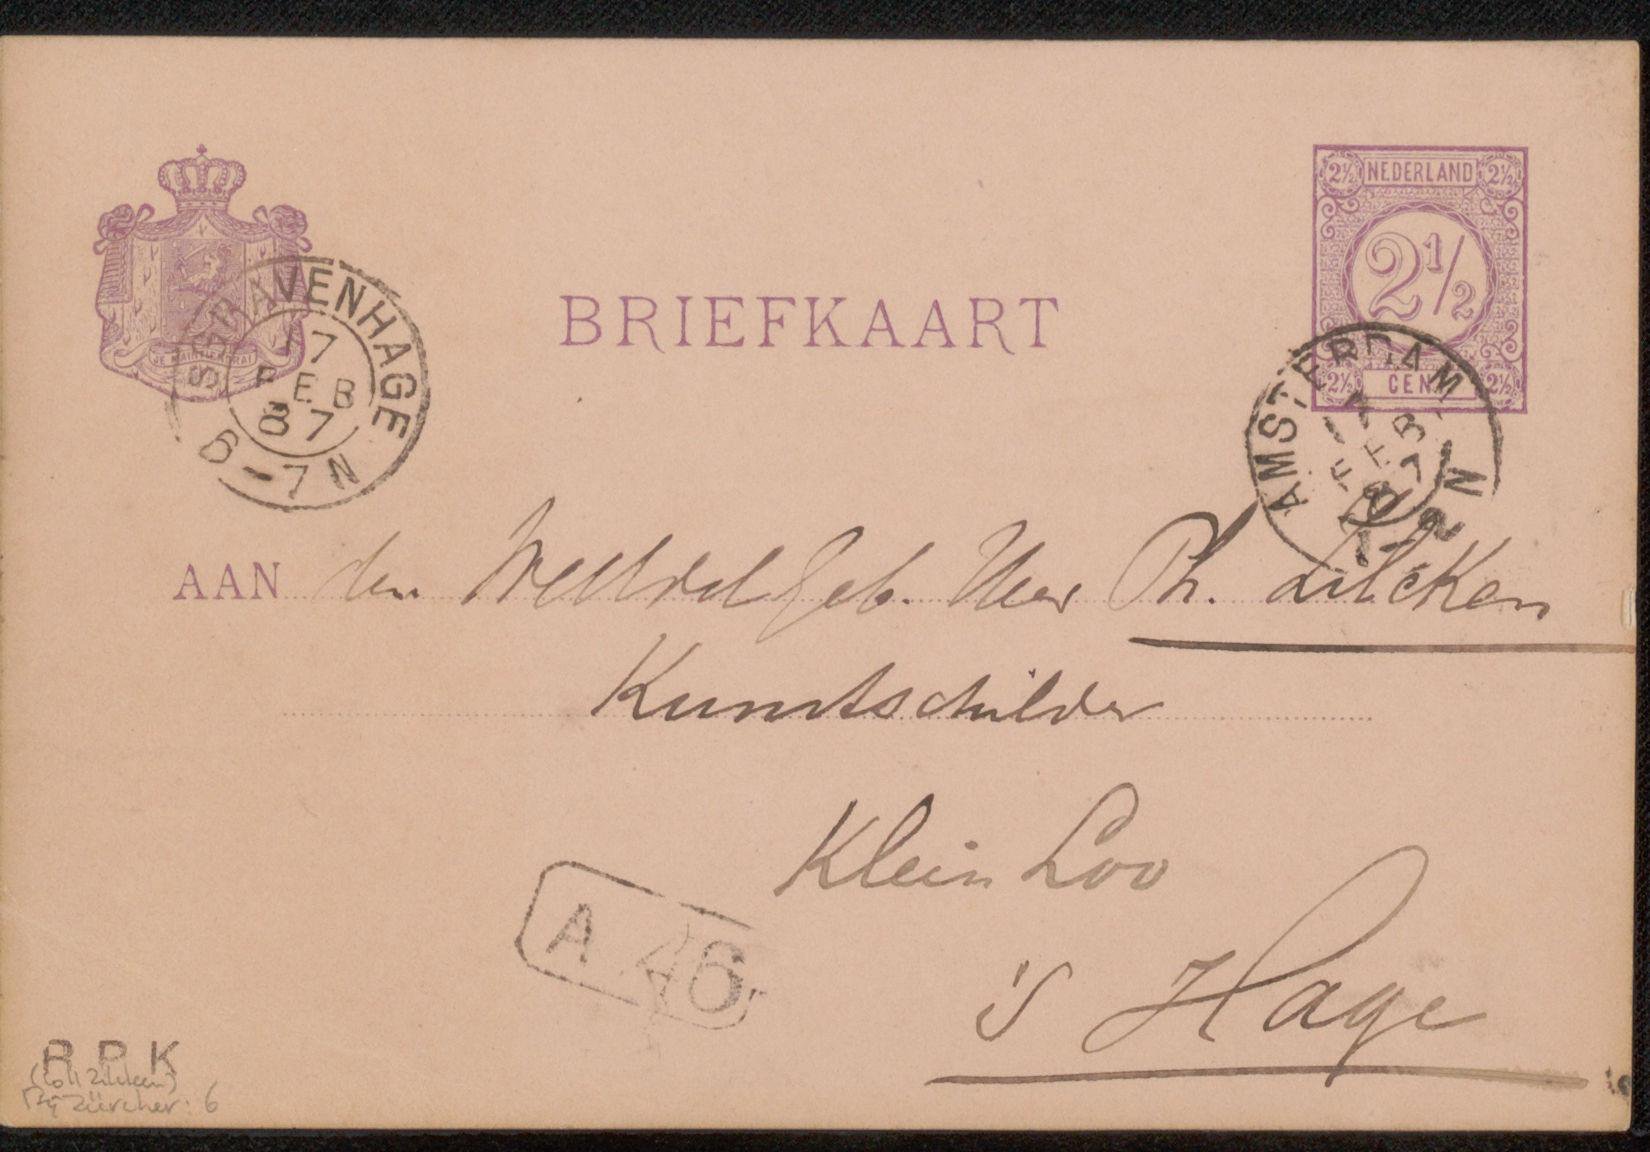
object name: postcard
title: Briefkaart aan Philip Zilcken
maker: jan zürcher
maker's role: painter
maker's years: 1851-1905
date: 1887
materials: cardboard, ink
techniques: pen, writing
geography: amsterdam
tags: draughtsman, philip zilcken, the graphic arts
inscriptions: collector's mark: ‘RPK’